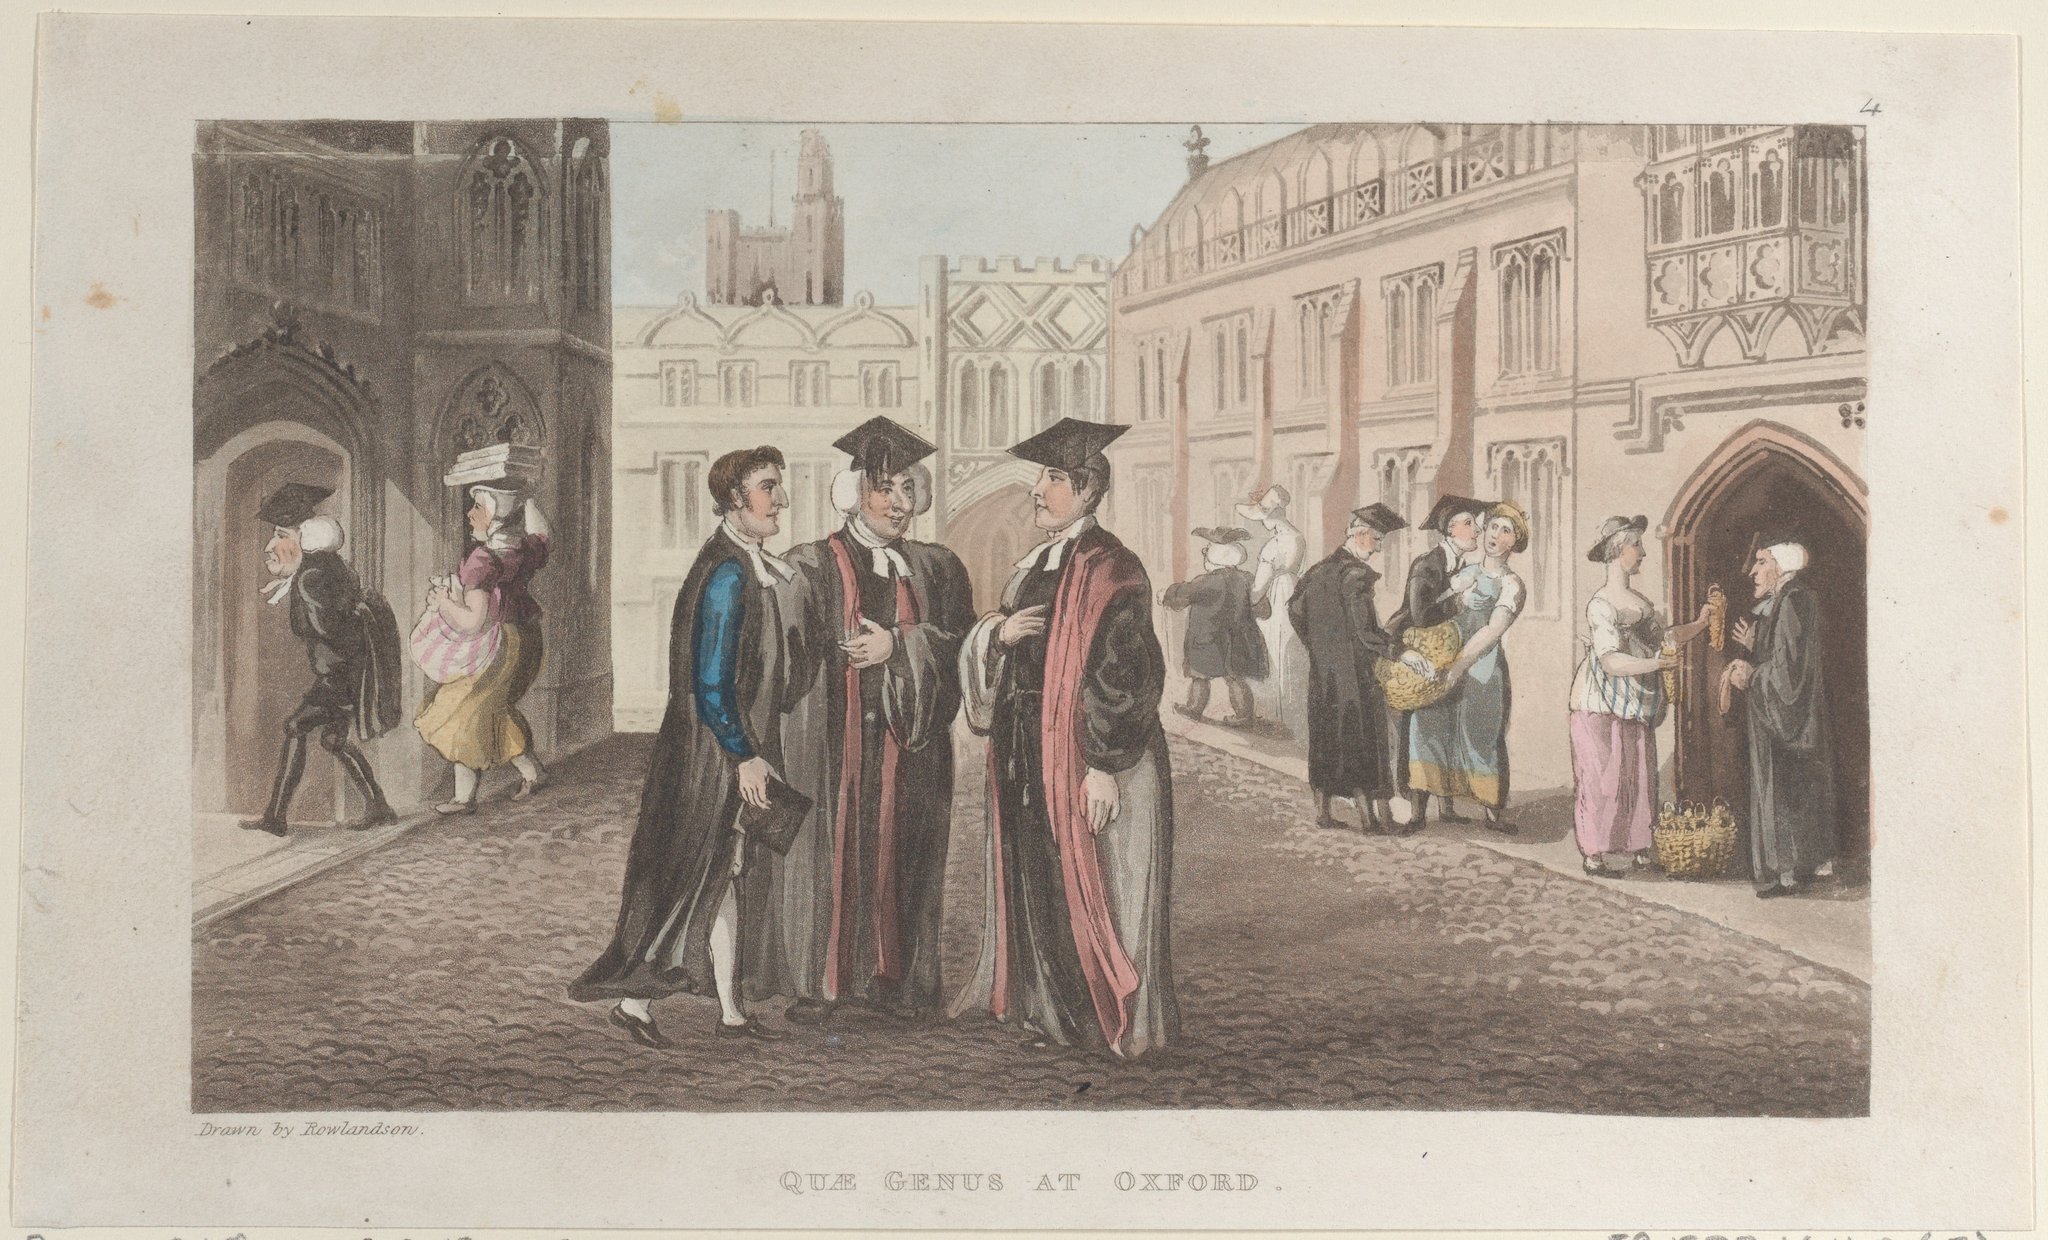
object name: print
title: Quae Genus at Oxford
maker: thomas rowlandson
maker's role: artist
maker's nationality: british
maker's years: 1757-1827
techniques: aquatint, etching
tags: men,women